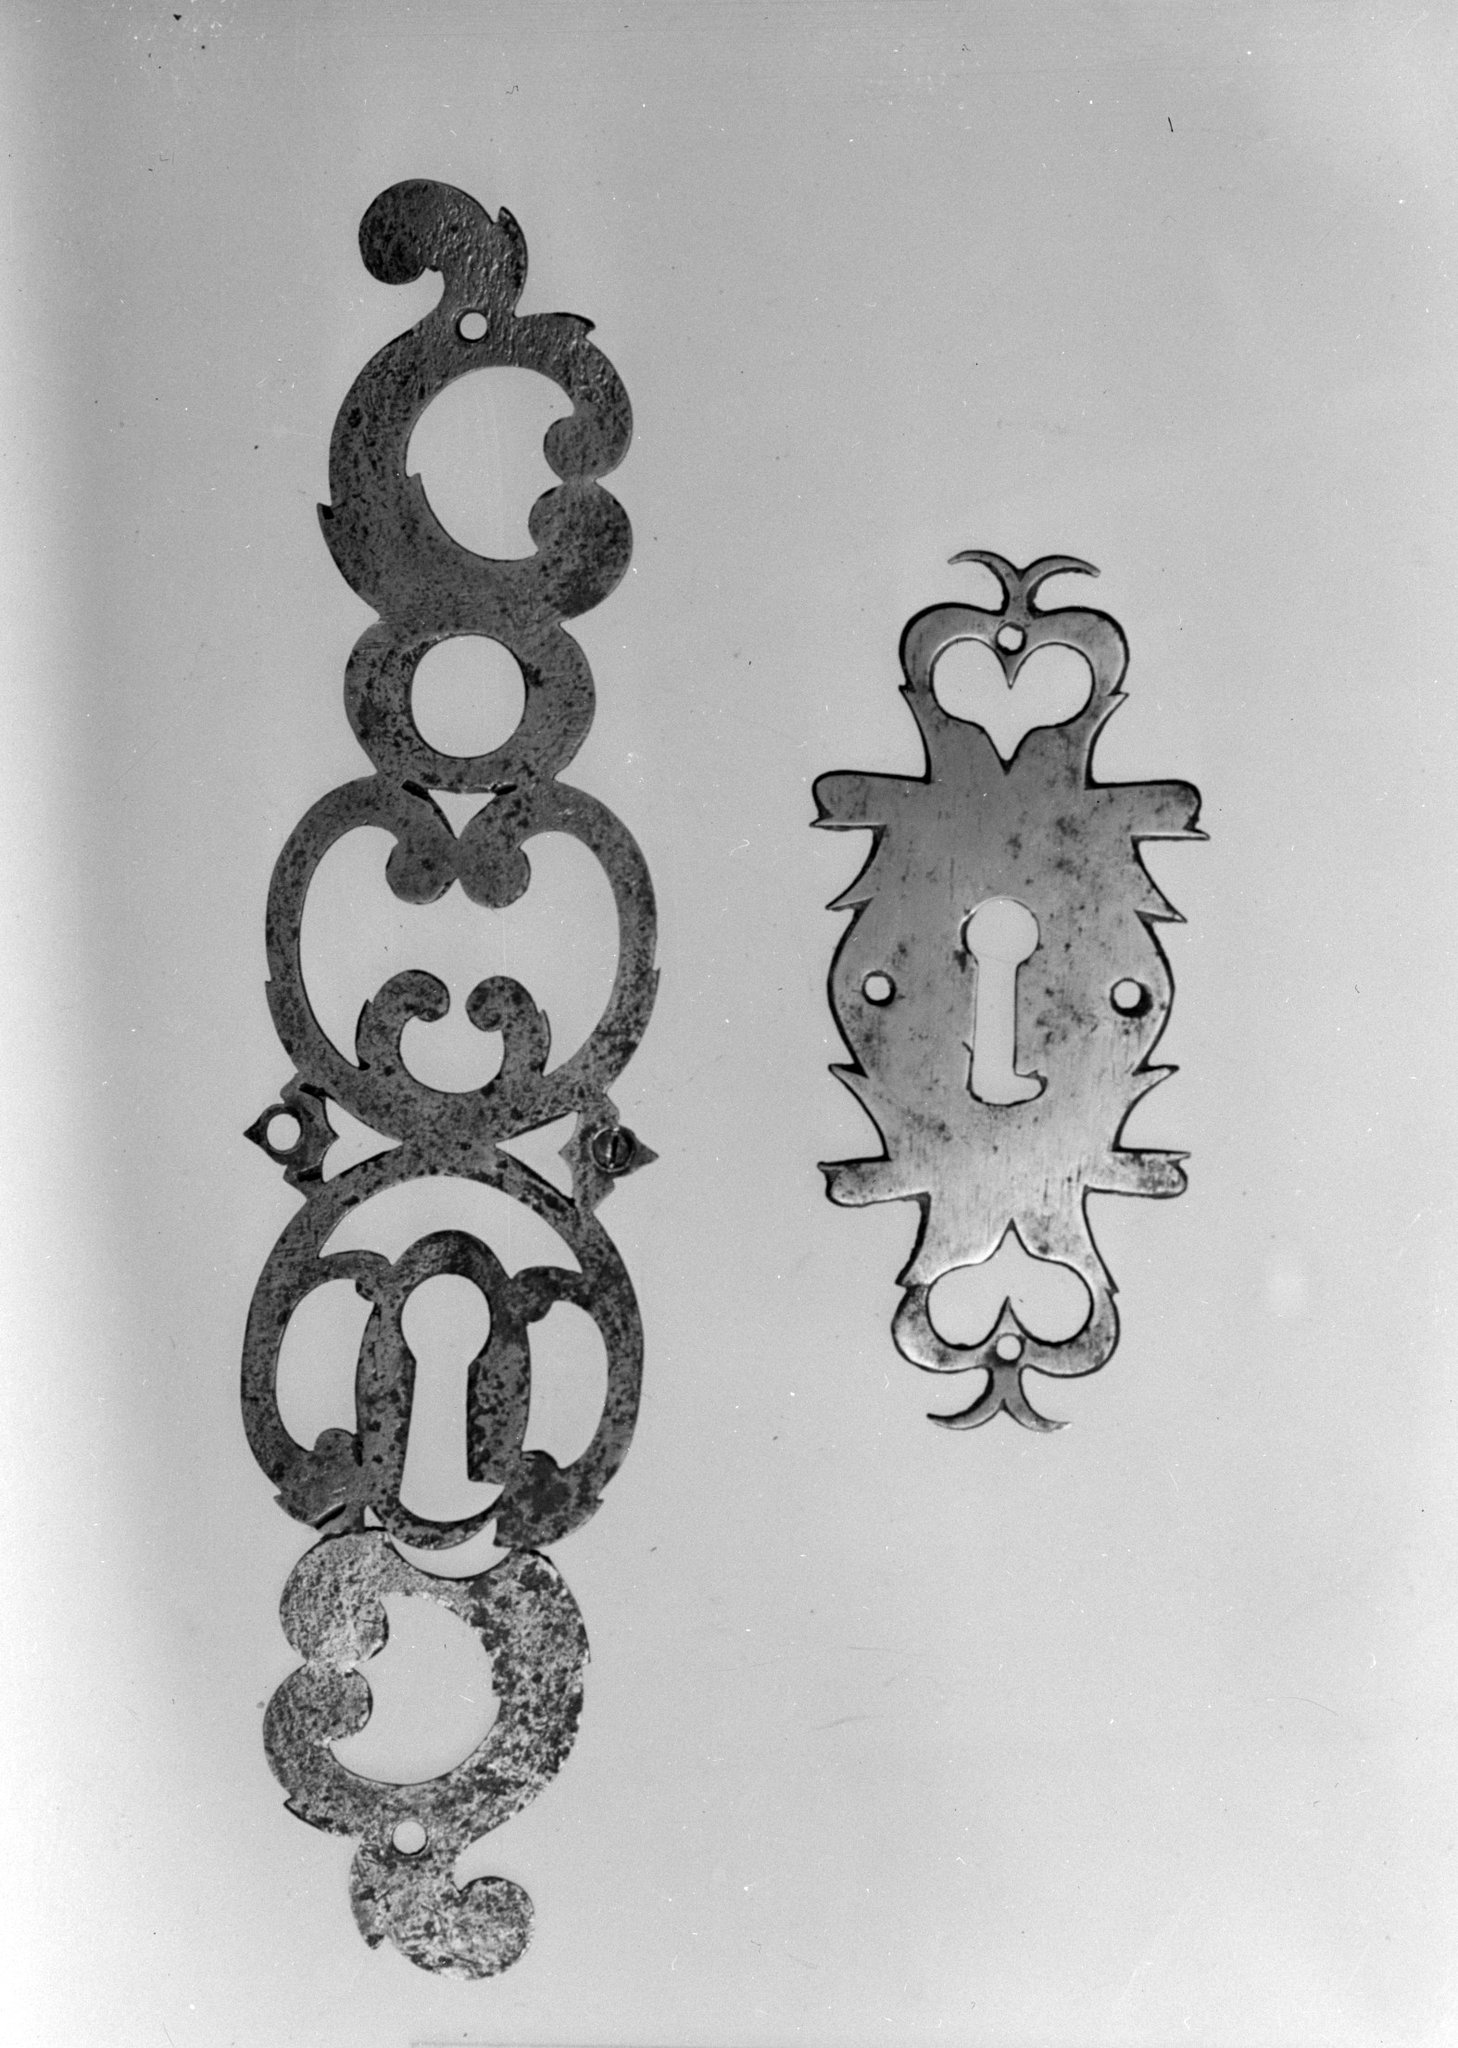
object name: escutcheon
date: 1700-1800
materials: iron